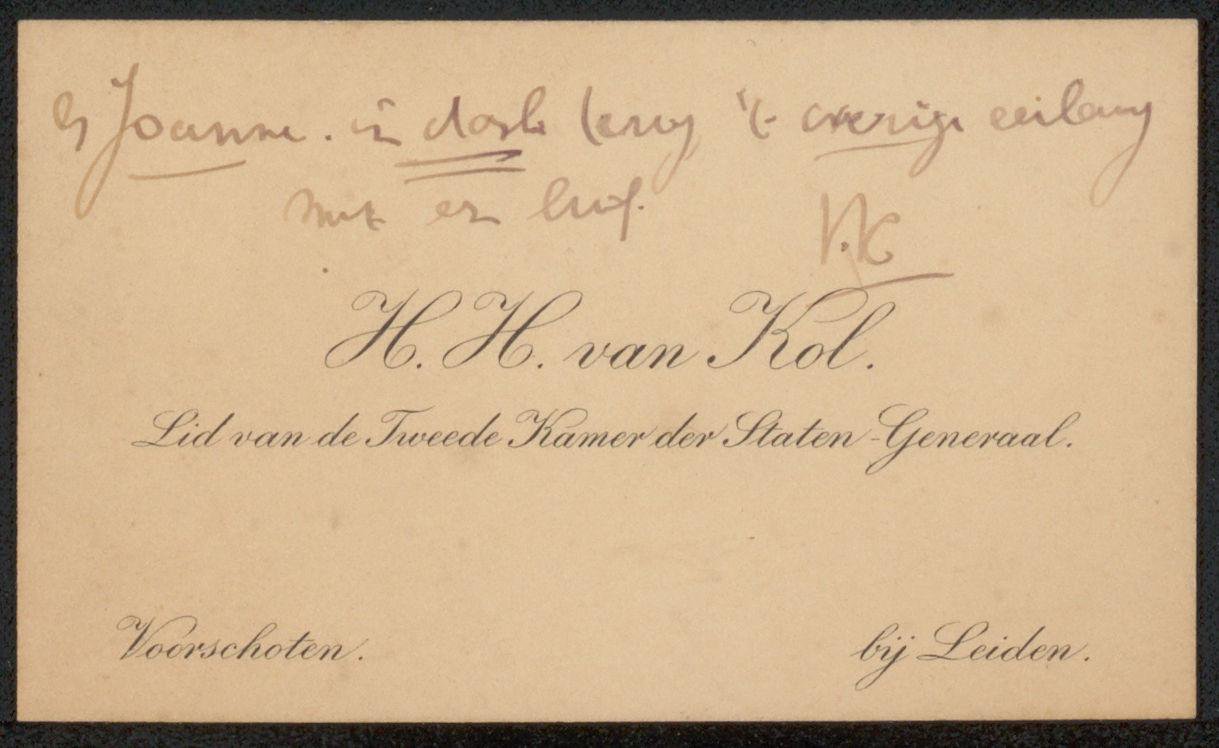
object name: visiting card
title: Visitekaartje aan Philip Zilcken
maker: hendrikus hubertus van kol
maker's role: engineer, politician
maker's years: 1852-1925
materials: cardboard, ink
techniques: pen, printing, writing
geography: voorschoten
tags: painter, draughtsman, philip zilcken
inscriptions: collector's mark: ‘RPK’